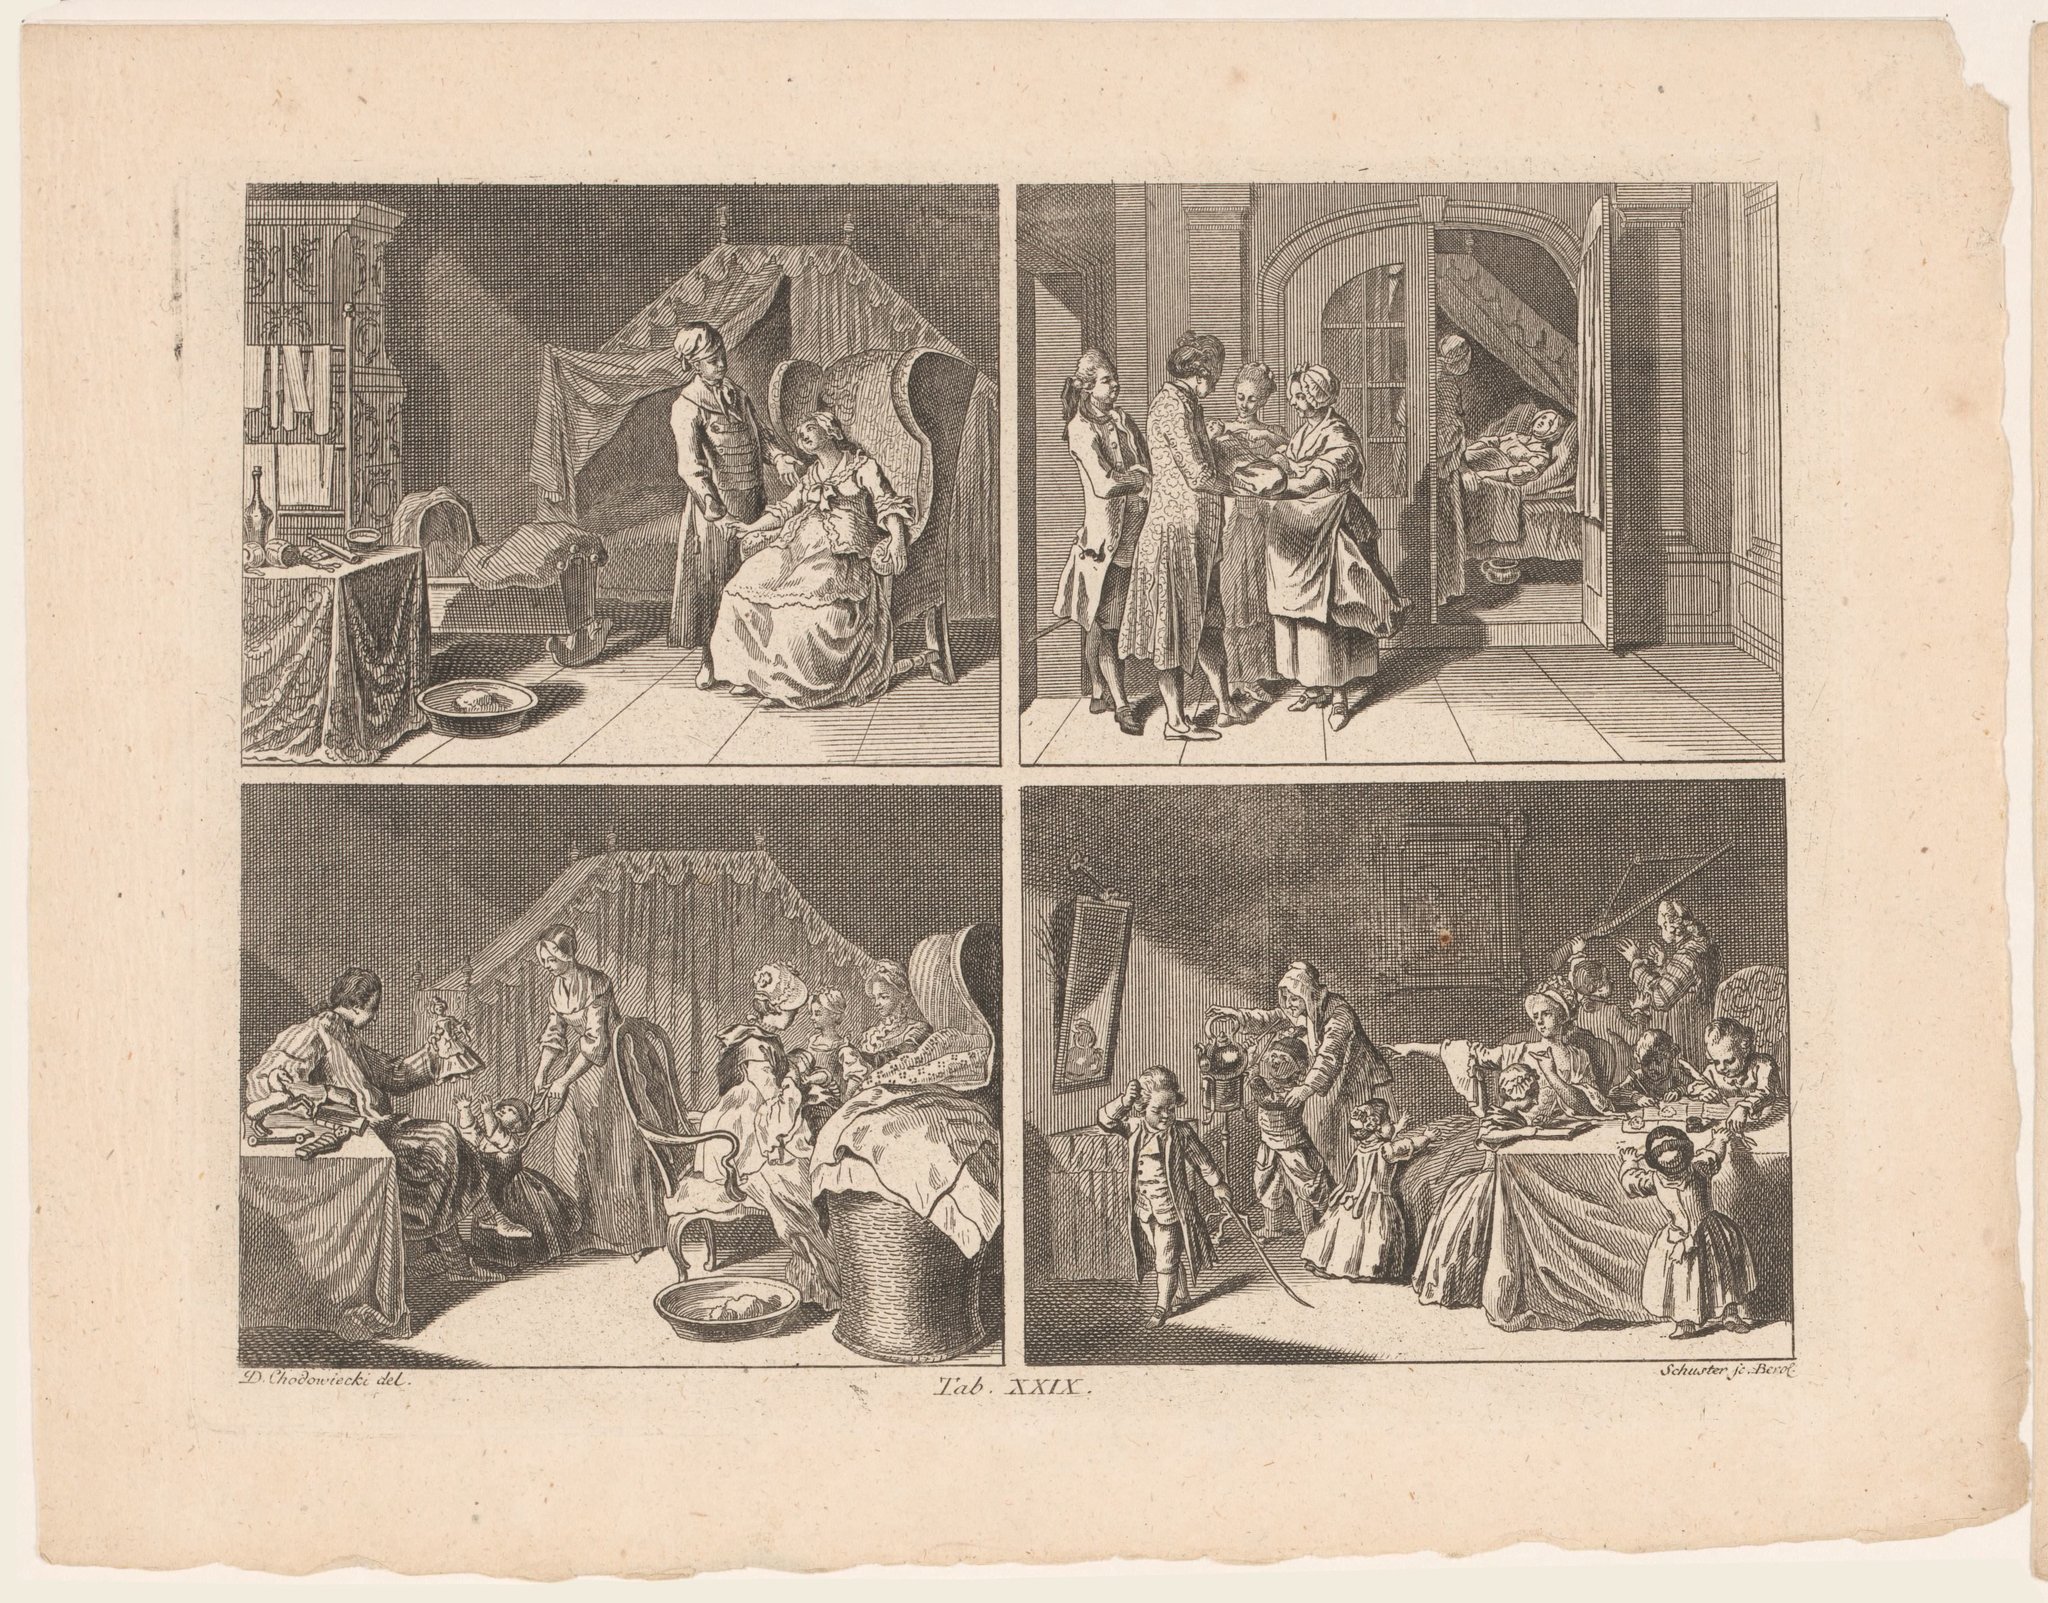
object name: print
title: Drie vrome spreuken, vorstelijk dis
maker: j.f. schuster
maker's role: print maker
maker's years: 1720-1796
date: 1774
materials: paper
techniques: etching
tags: proverbs, sayings, etc.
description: Prent ook gebruikt in: Basedow, Johann Bernhard. Das Basedowische Elementarwerk. Ein Vorrath der besten Erkenntnisse zum Lernen, Lehren, Wiederholen und Nachdenken. Leipzig: Siegfried Lebrecht Crucius, 1774.